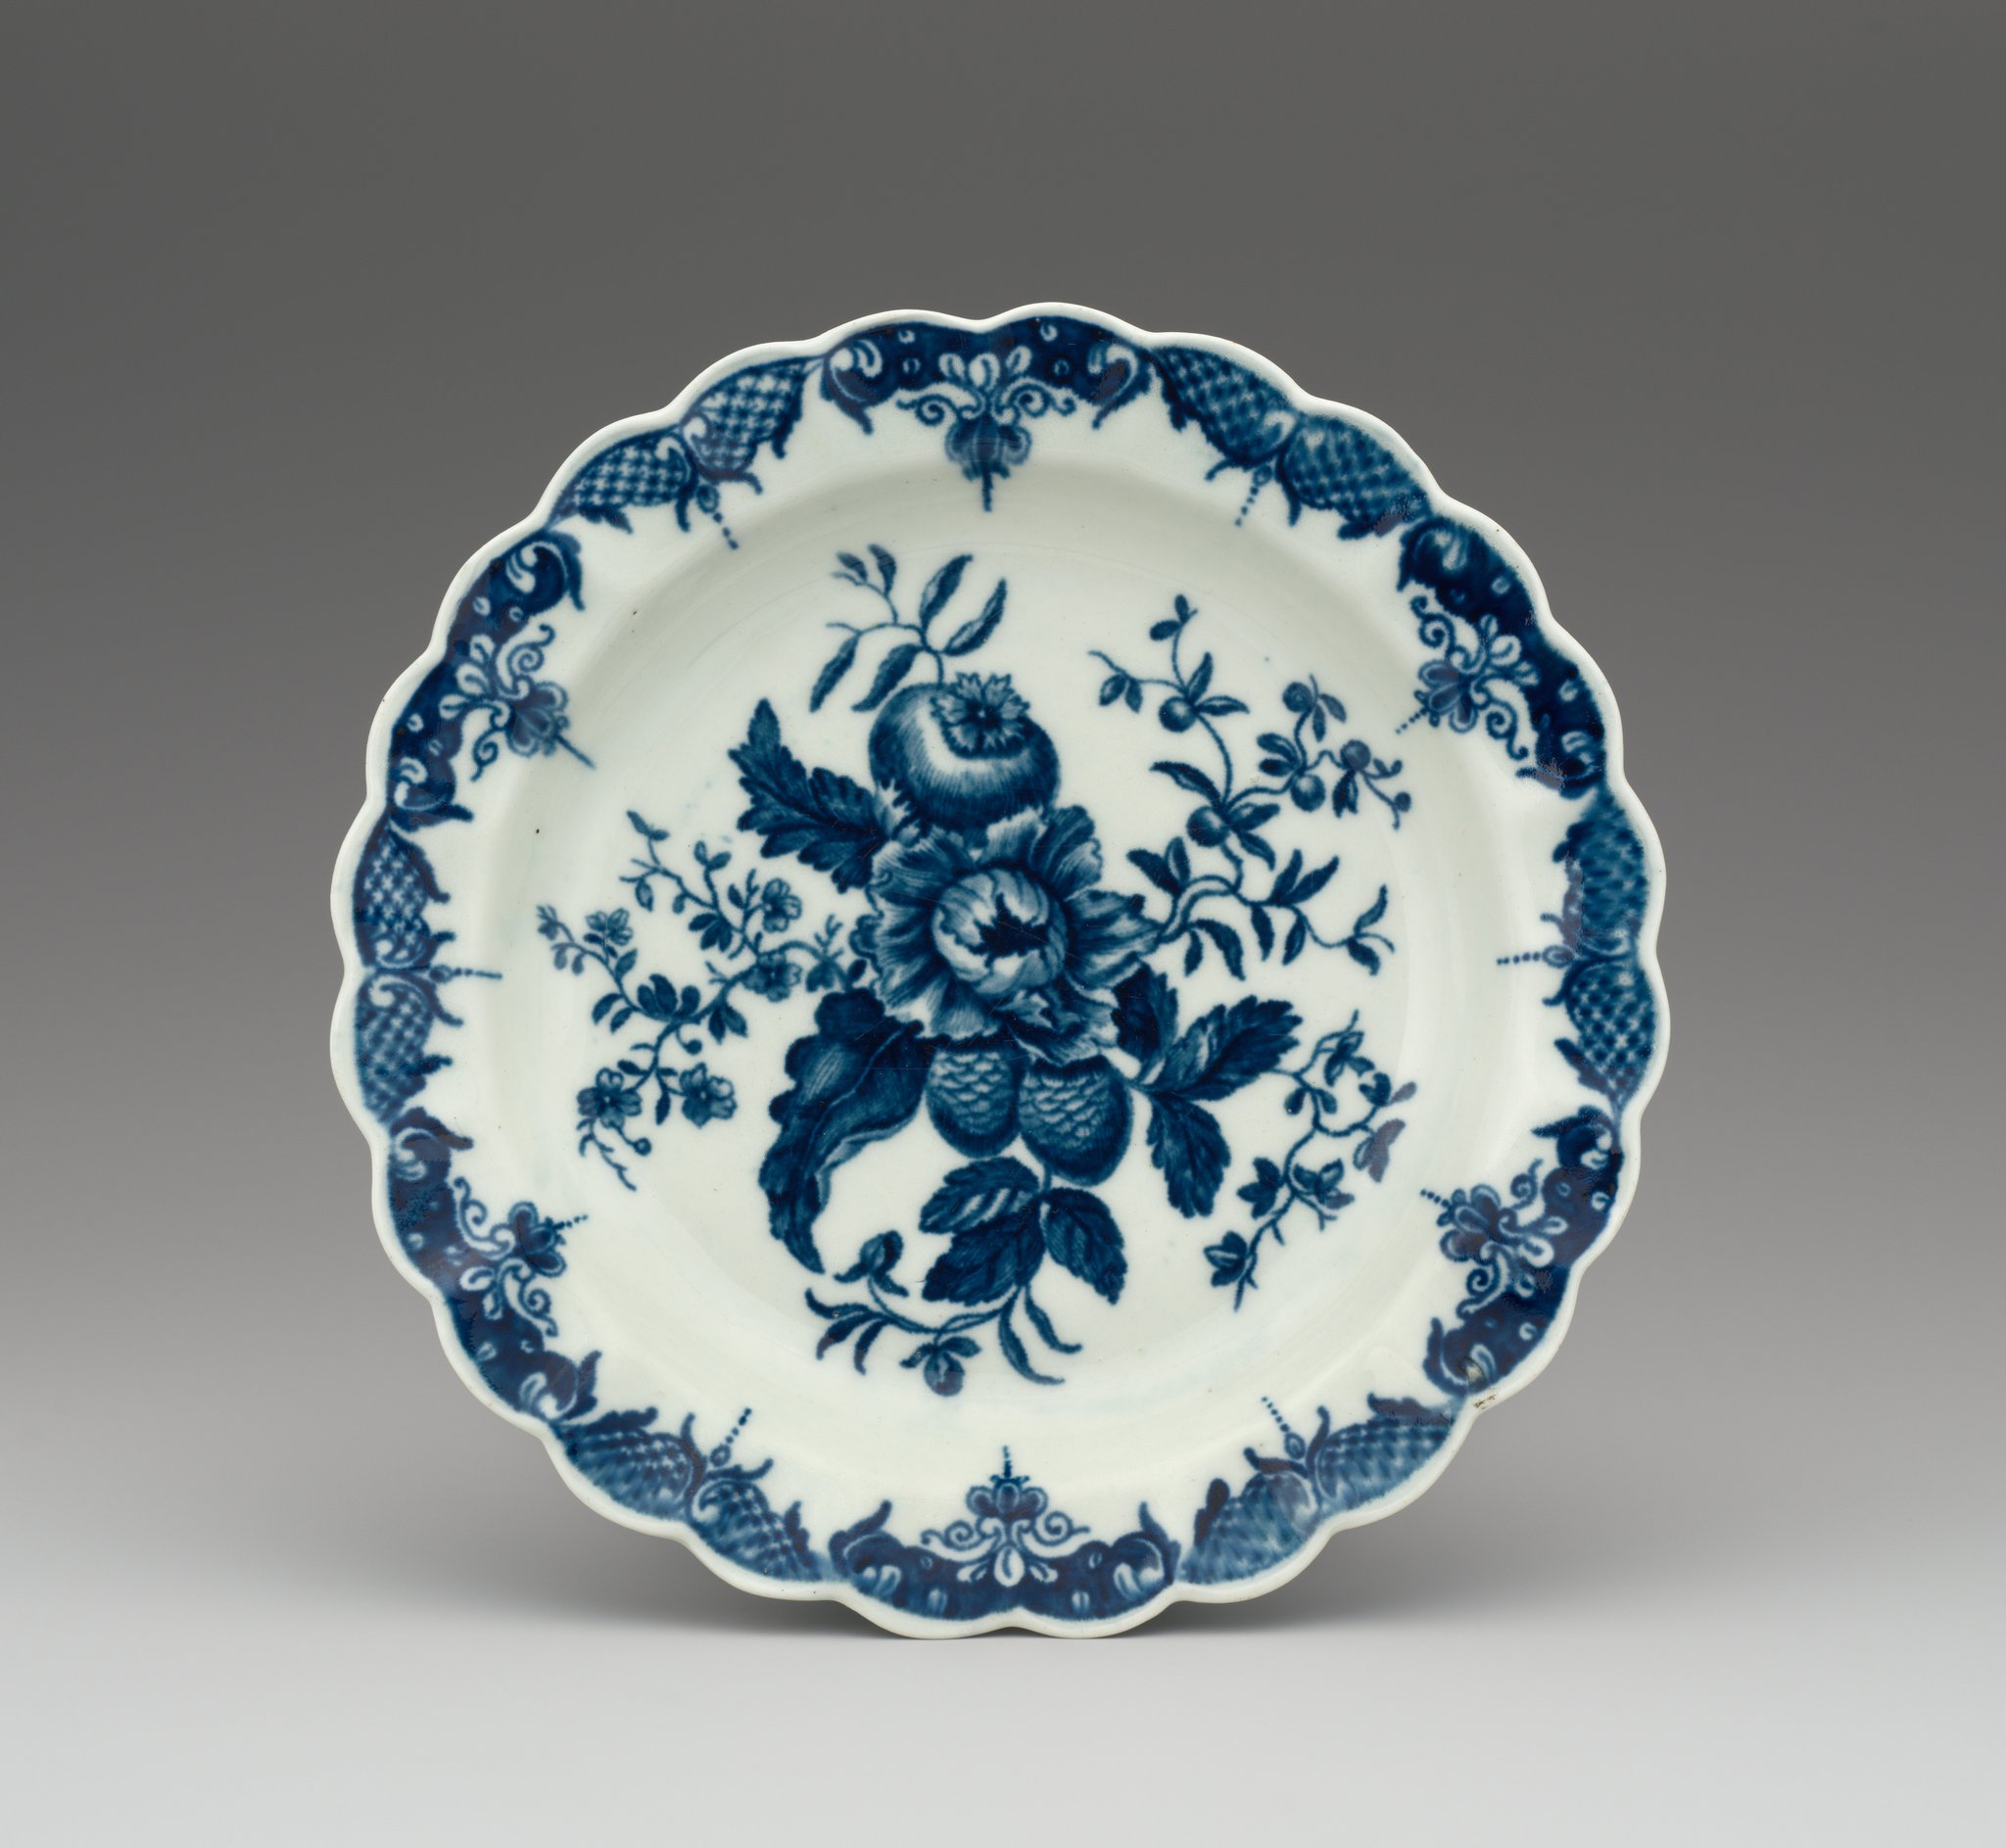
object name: dish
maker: worcester factory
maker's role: factory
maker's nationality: british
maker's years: 1751-2008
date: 1770-1775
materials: soft paste porcelain